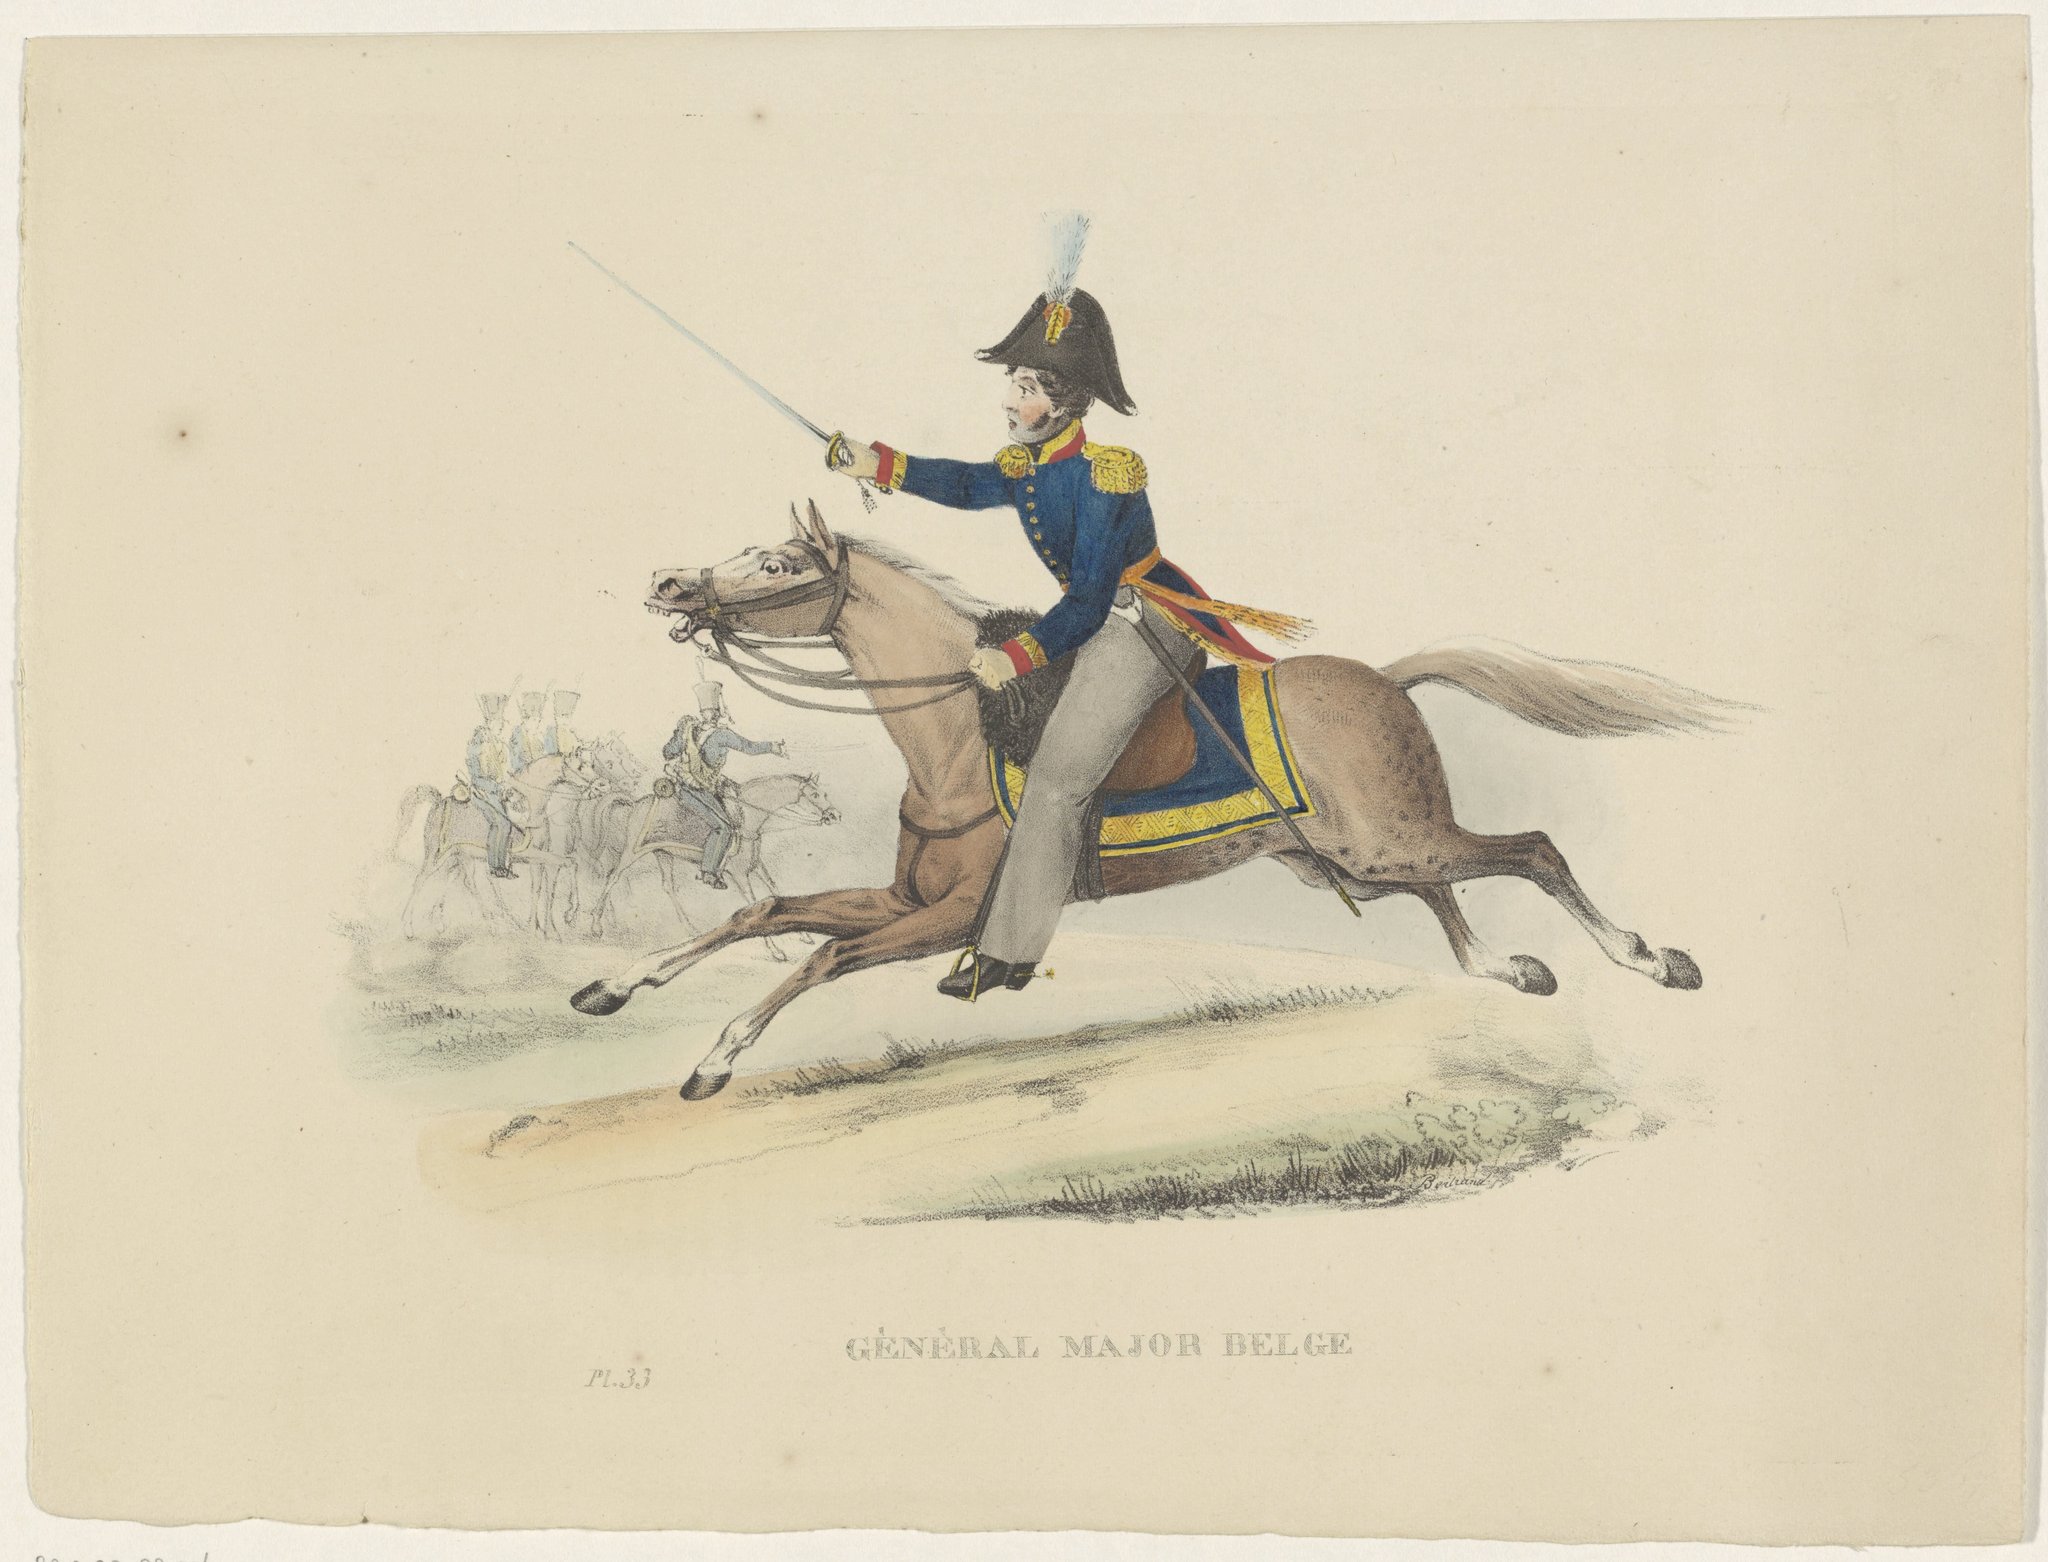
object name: costume print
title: Costumes belgiques: anciens et modernes, militaires, civils et religieux, 1830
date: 1830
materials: paper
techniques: hand coloring, lithograph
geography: brussels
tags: (military) uniforms, clothes, costume, belgium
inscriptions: collector's mark: Lugt 2228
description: Een Belgische generaal-majoor te paard met getrokken degen, 1830. Genummerd linksonder: Pl. 33. Onderdeel van een serie van Belgische klederdrachten, gedrukt bij Jobard in 1830.